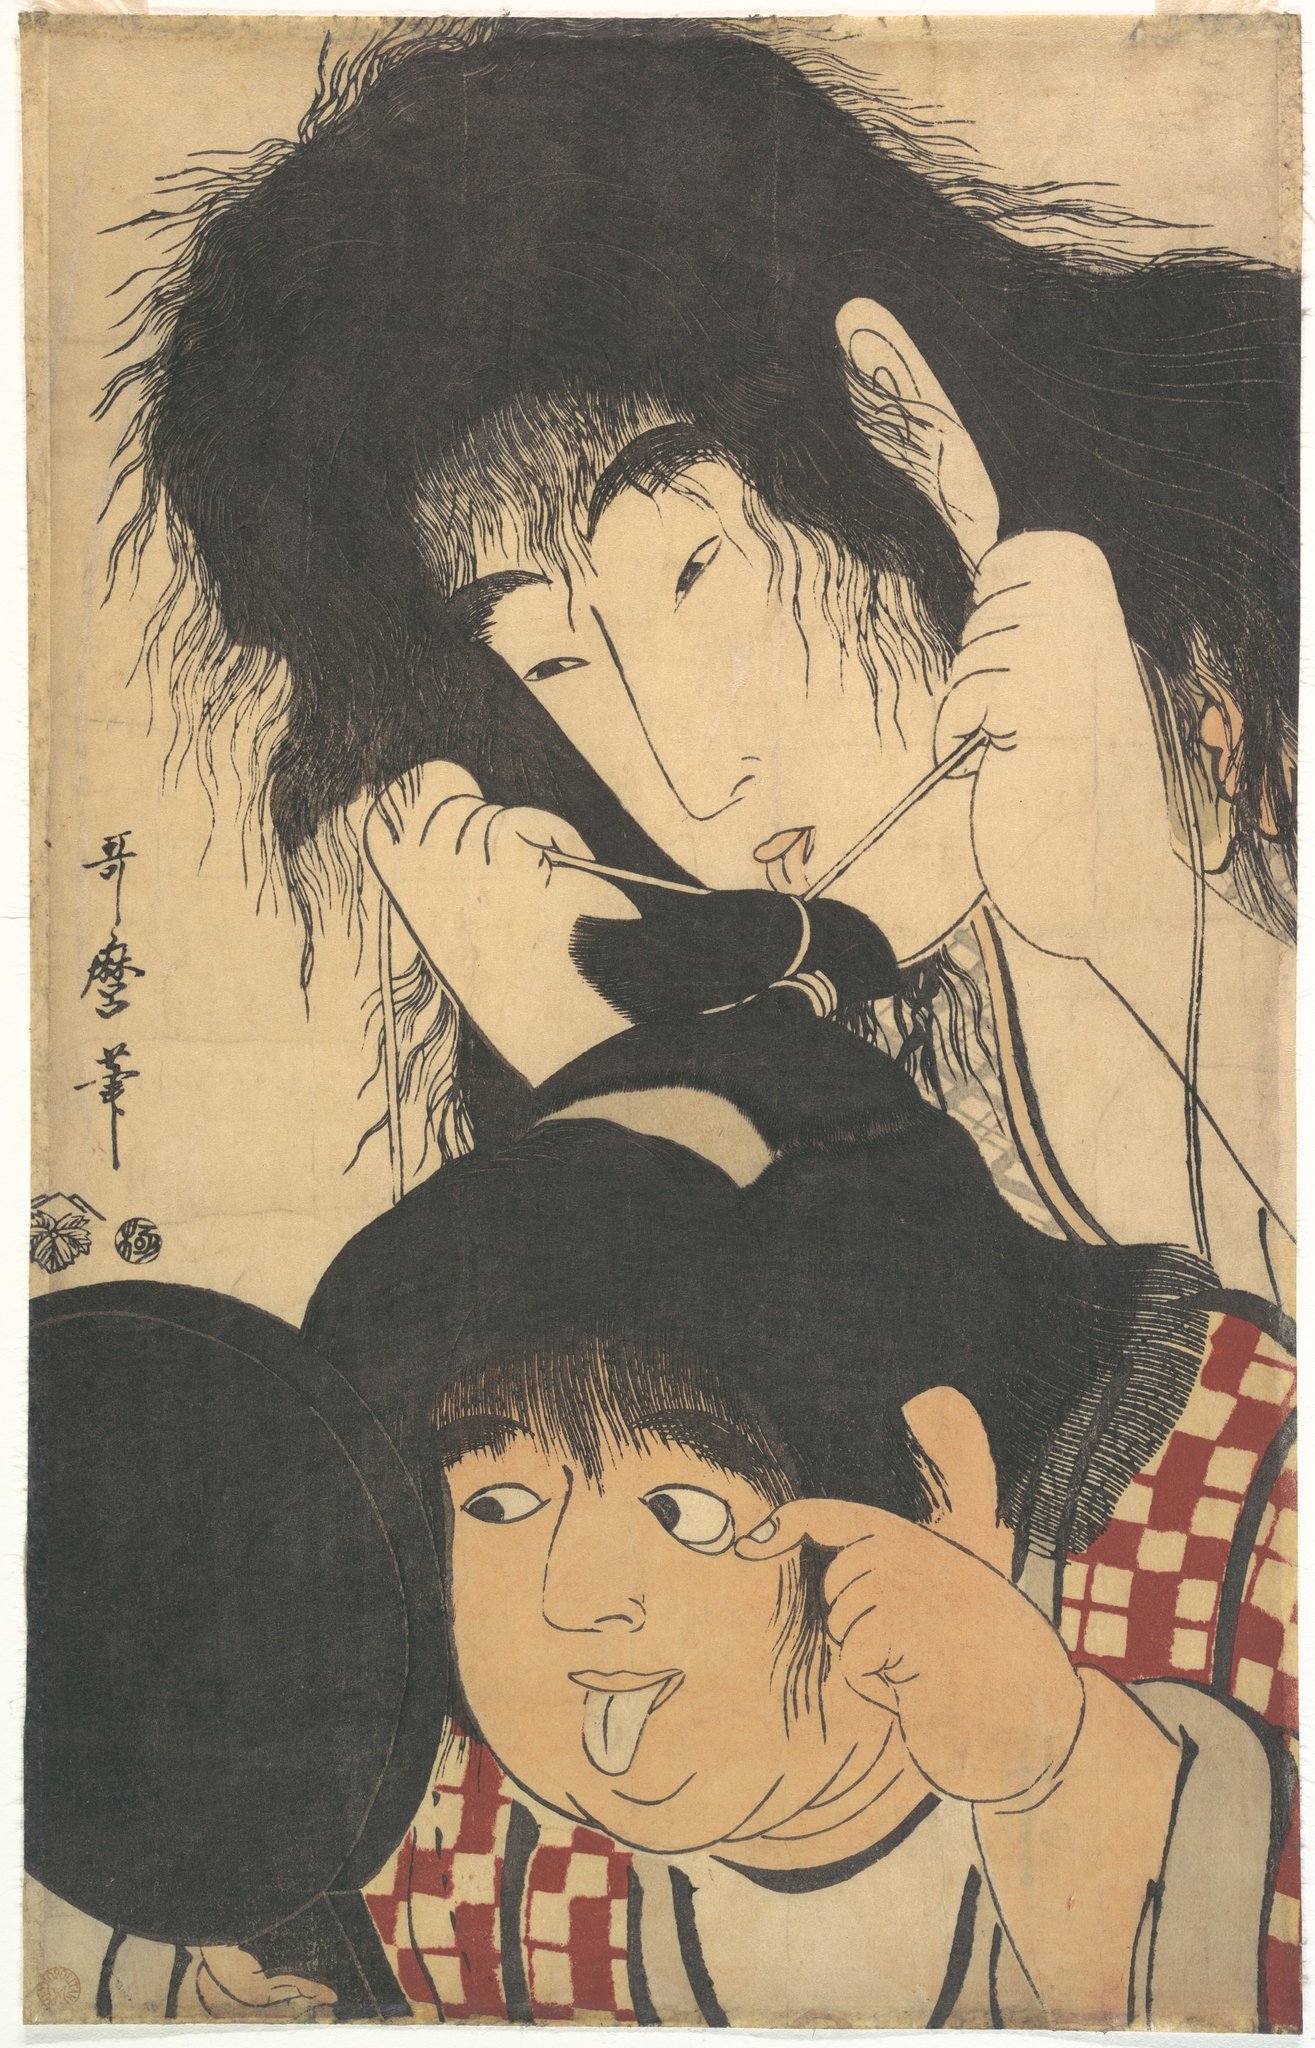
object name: print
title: Yamauba Tying Kintarō’s Topknot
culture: japanese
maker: kitagawa utamaro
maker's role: artist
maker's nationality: japanese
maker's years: 1754-1806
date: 1795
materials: ink, paper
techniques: nishiki e, woodblock print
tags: hair,boys,women,mirrors